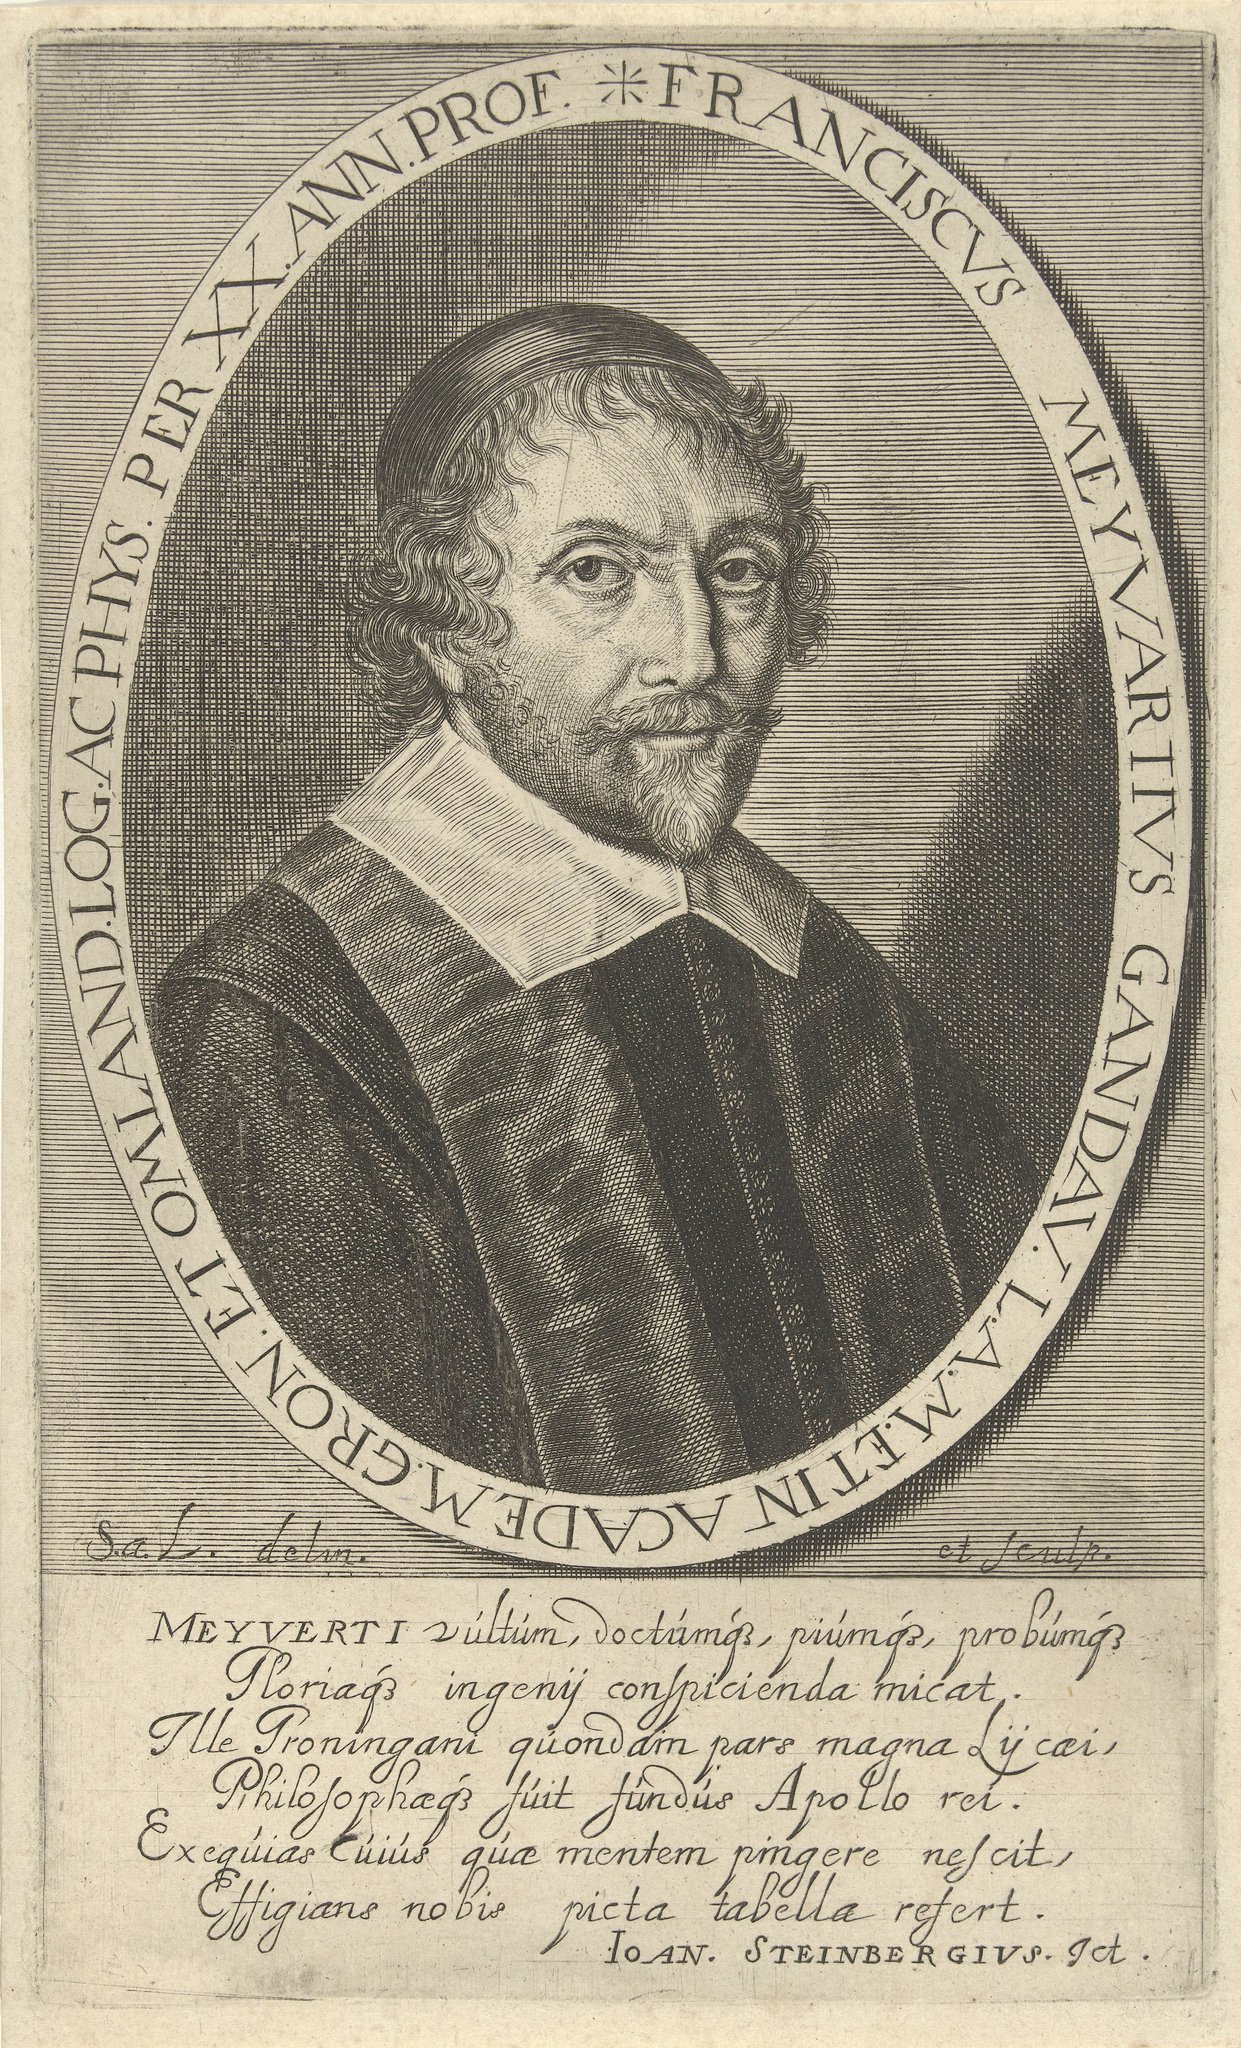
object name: print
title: Portret van Franciscus Meyvartius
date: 1654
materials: paper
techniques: engraving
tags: professor, franciscus meyvartius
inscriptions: collector's mark: Lugt 2228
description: Portretbuste in ovaal naar rechts van Franciscus Meyvartius, hoogleraar te Groningen, met kalot. Op de ovale omlijsting staat een randschrift in Latijn, in de marge een achtregelig Latijns vers.